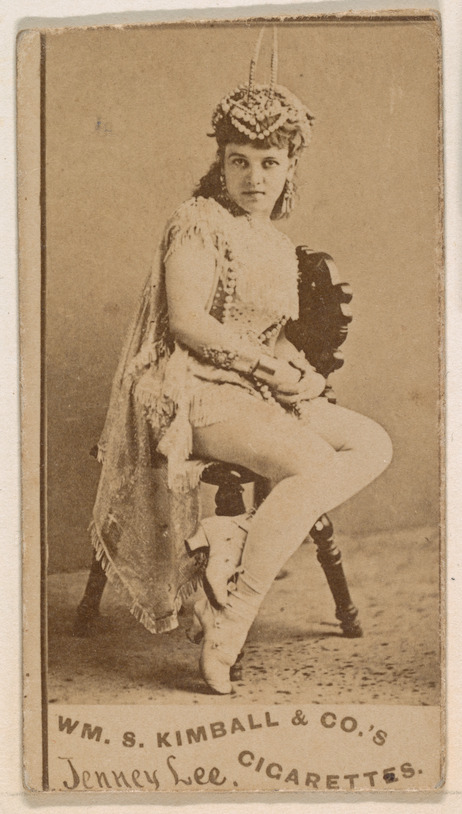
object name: photograph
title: Jenny Lee, from the Actresses series (N203) issued by Wm. S. Kimball & Co.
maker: william s. kimball & company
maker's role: publisher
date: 1889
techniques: color lithograph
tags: portraits,women,actresses